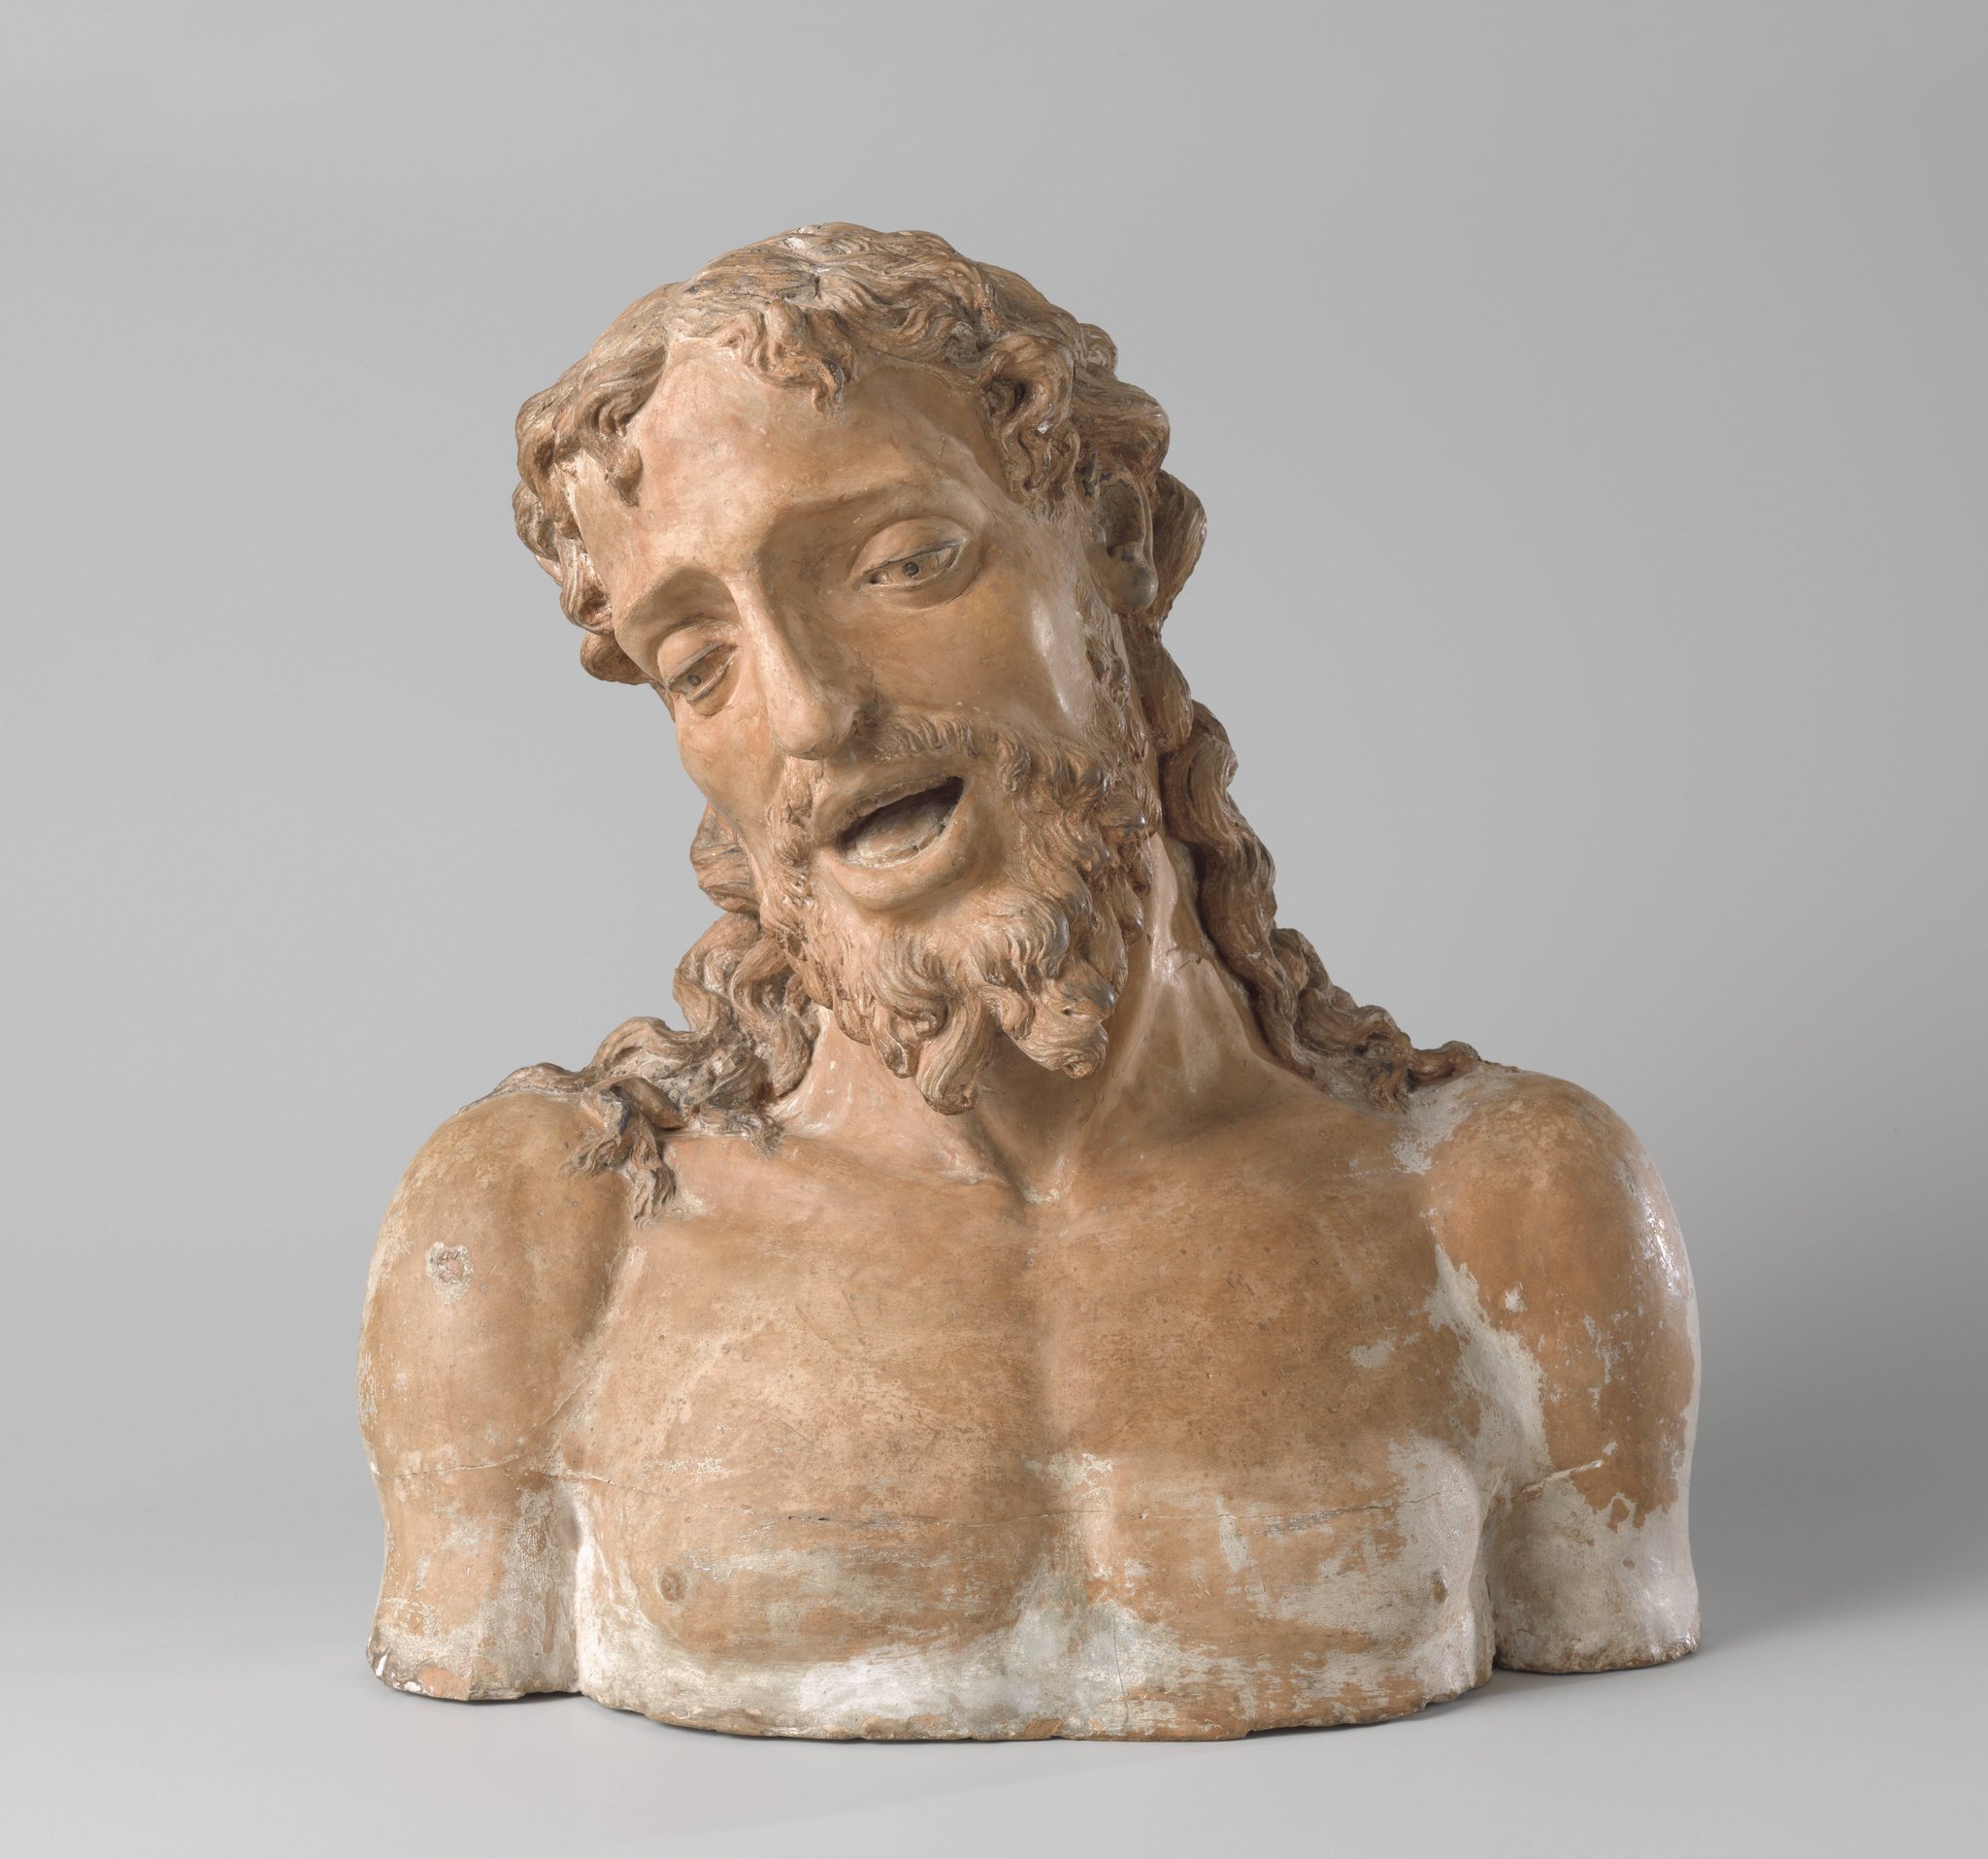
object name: sculpture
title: Christ as the Man of Sorrows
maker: ludovico begarelli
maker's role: sculptor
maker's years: 1414-1477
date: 1530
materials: terracotta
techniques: modeling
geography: modena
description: This impressive bust was originally part of a full-length statue of the Risen Christ, which showed his wounds. Such monumental and realistic portrayals in terracotta were a speciality of Antonio Begarelli, who was considered one of the most important sculptors of his time in this medium.